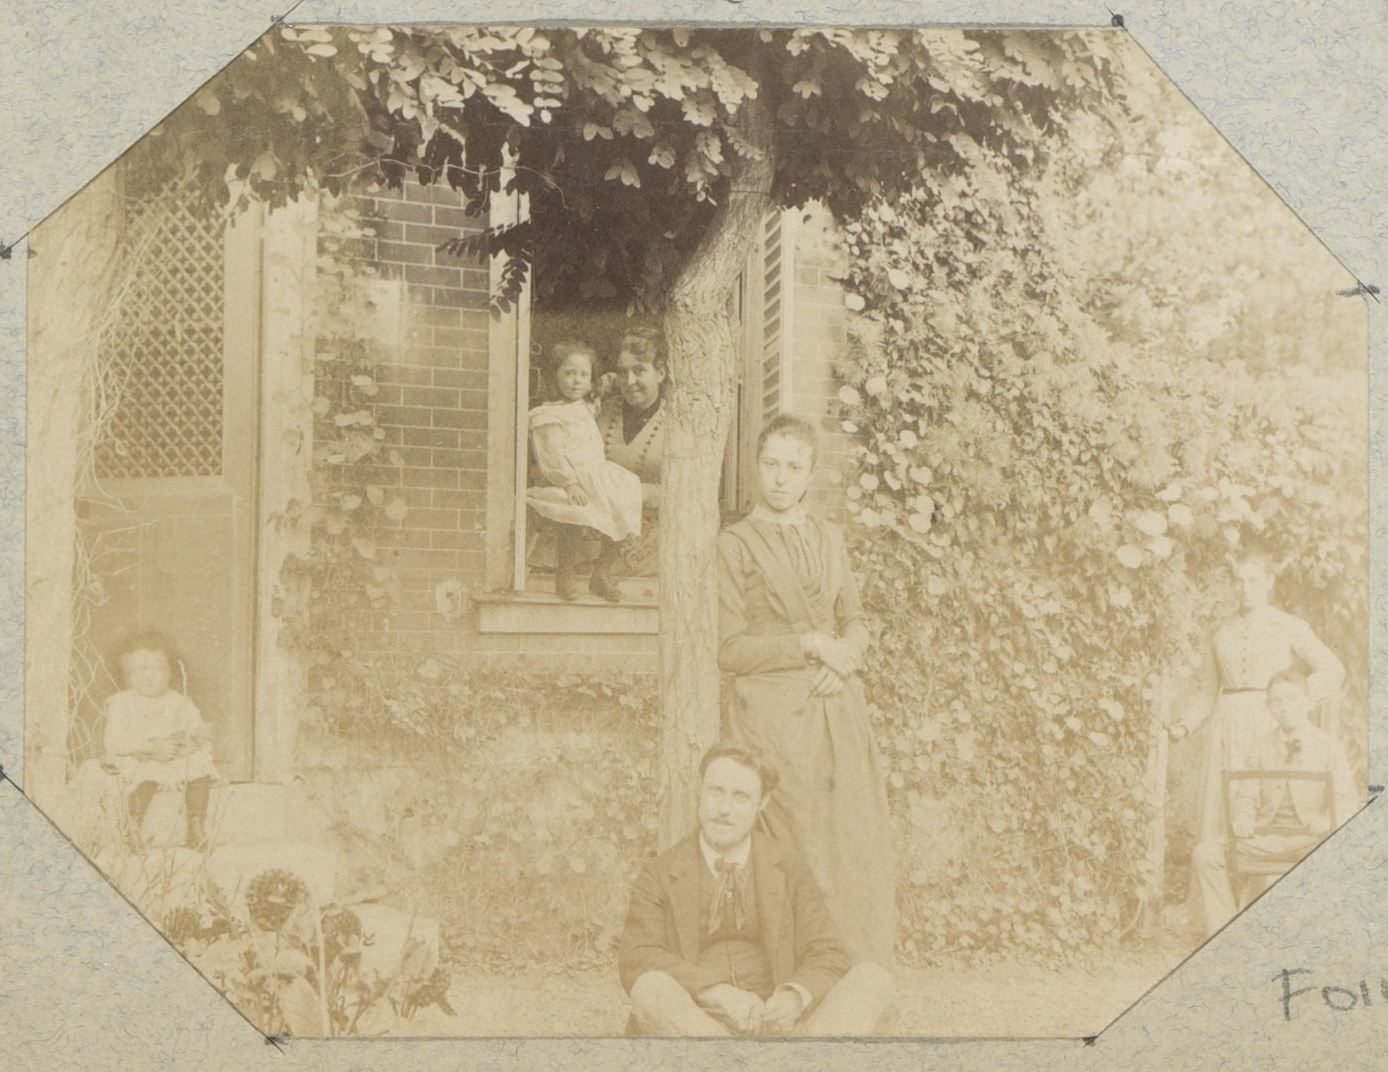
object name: album leaf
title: Groepsportret van een (vermoedelijk) Franse familie in een tuin bij een huis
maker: Anonymous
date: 1880-1900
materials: paper, photographic support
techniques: albumen print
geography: france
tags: family group, especially parents with their child(ren), france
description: Onderdeel van Album van een Franse amateur met foto's van Frankrijk, Algerije, Palmyra, de Wereldtentoonstelling van 1900 en van bekende Fransen.